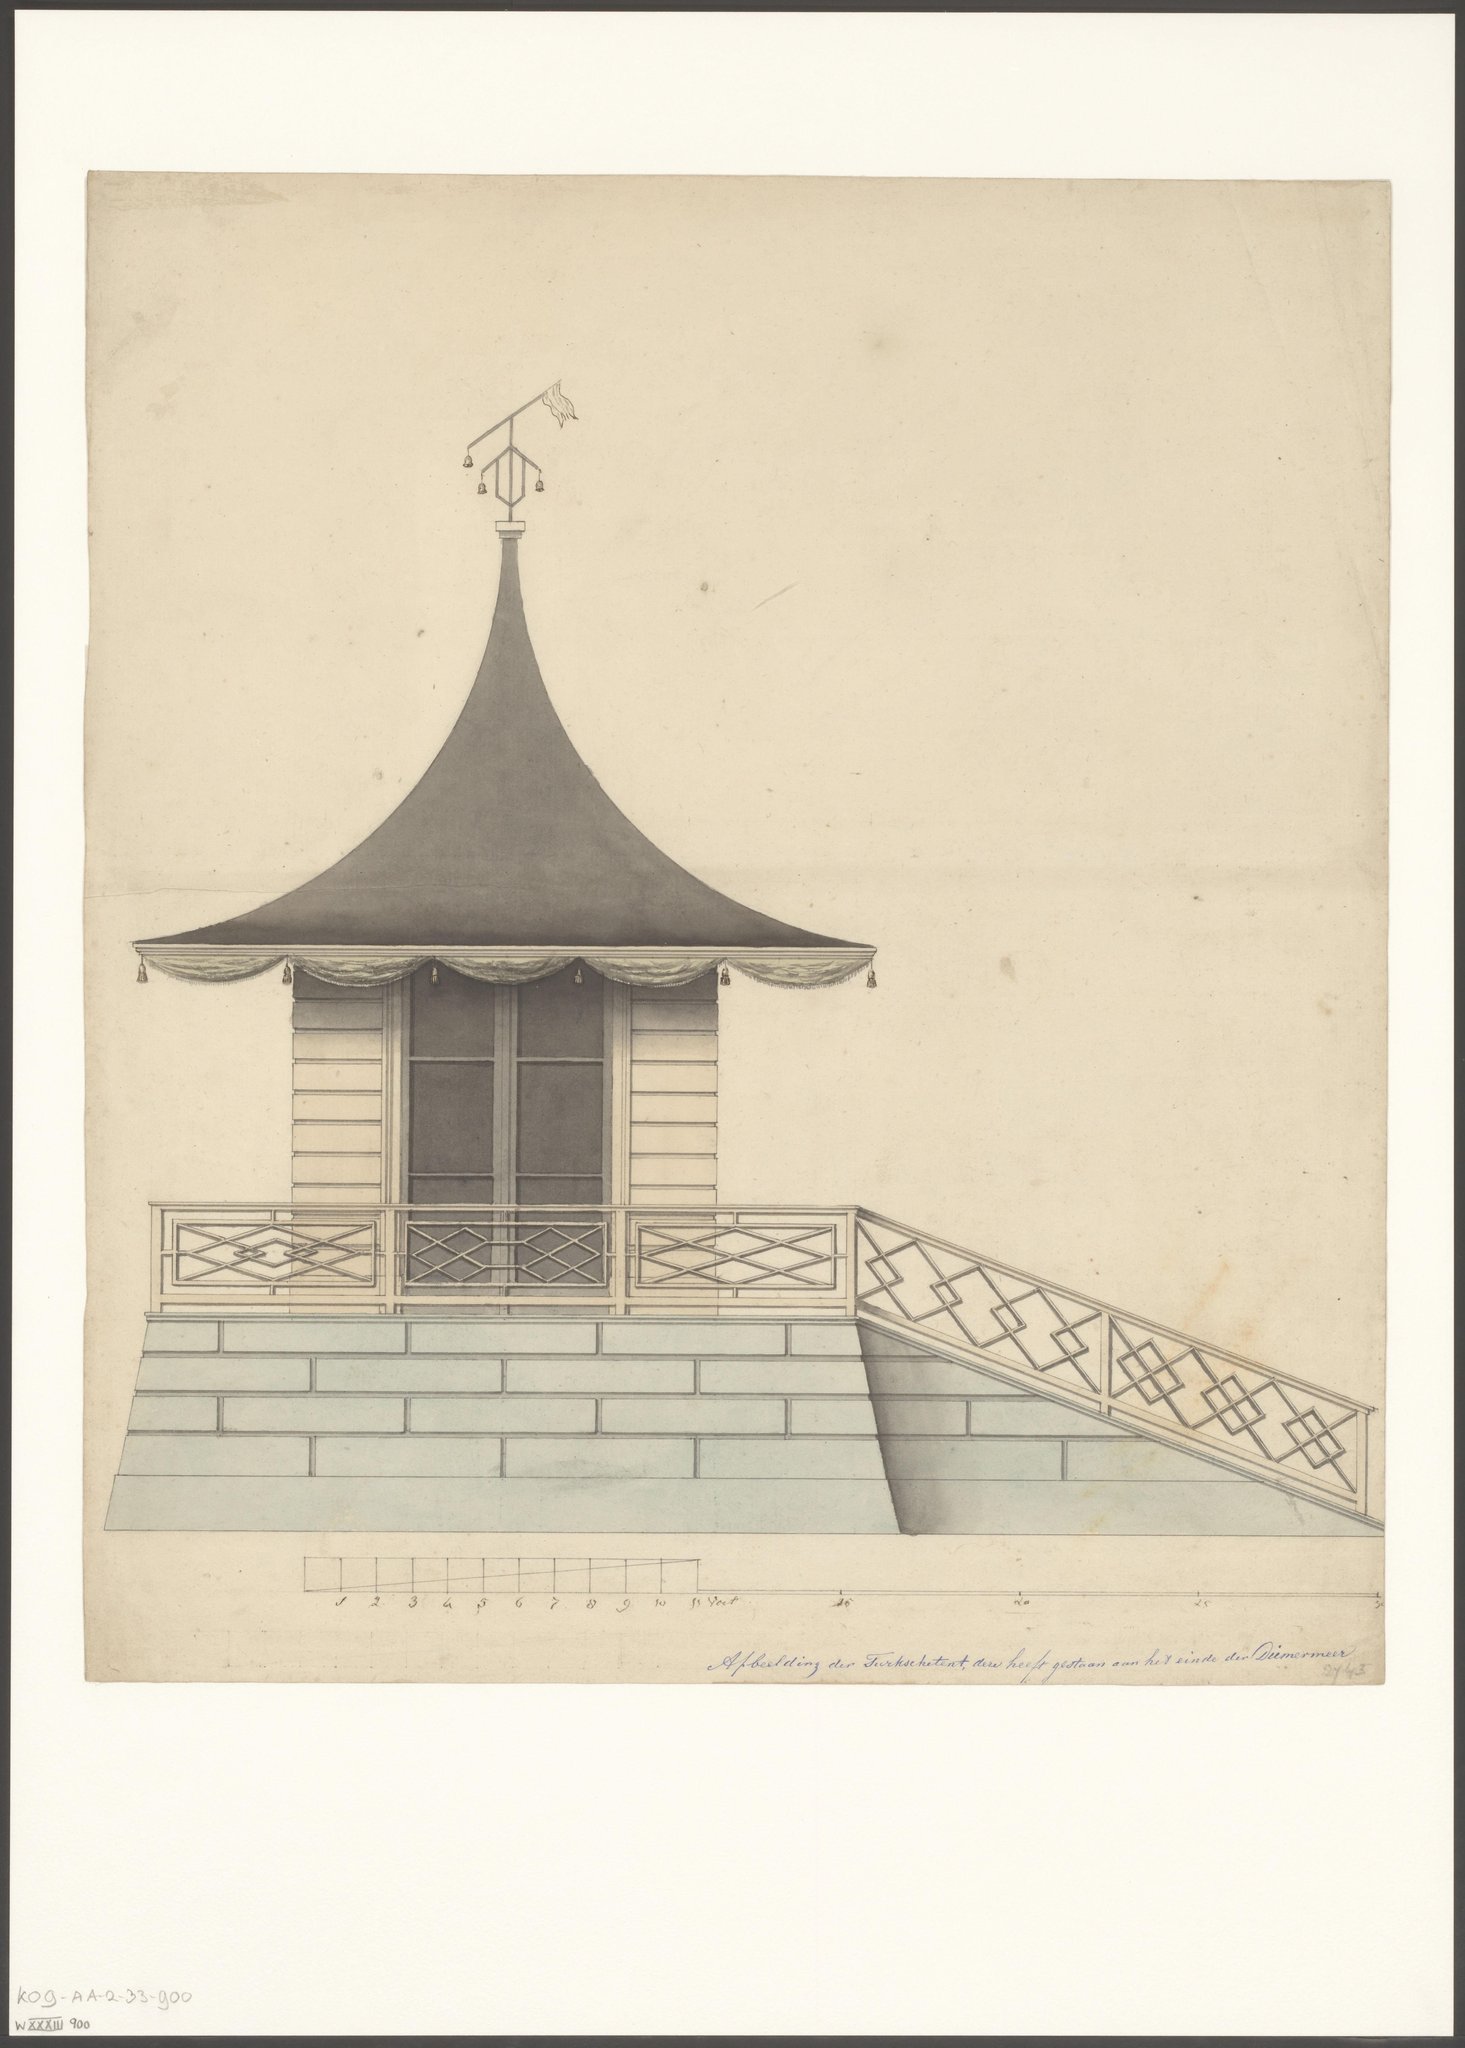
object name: drawing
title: Compositie met een deel van de Turkse Tent bij de Watergraafsmeer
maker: jan otto (tekenaar)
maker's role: draughtsman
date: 1750-1840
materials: ink, paper, pencil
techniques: brush, pen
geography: amsterdam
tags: ornaments ~ art, city-view in general; 'veduta', open-air recreation, façade (of house or building)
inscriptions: inscription: ‘Afbeelding der Turkschetent, deze heeft gestaan aan het einde der Diemermeer’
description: Tekening binnen de Atlas Van Eck ingedeeld op wijknummer 33.